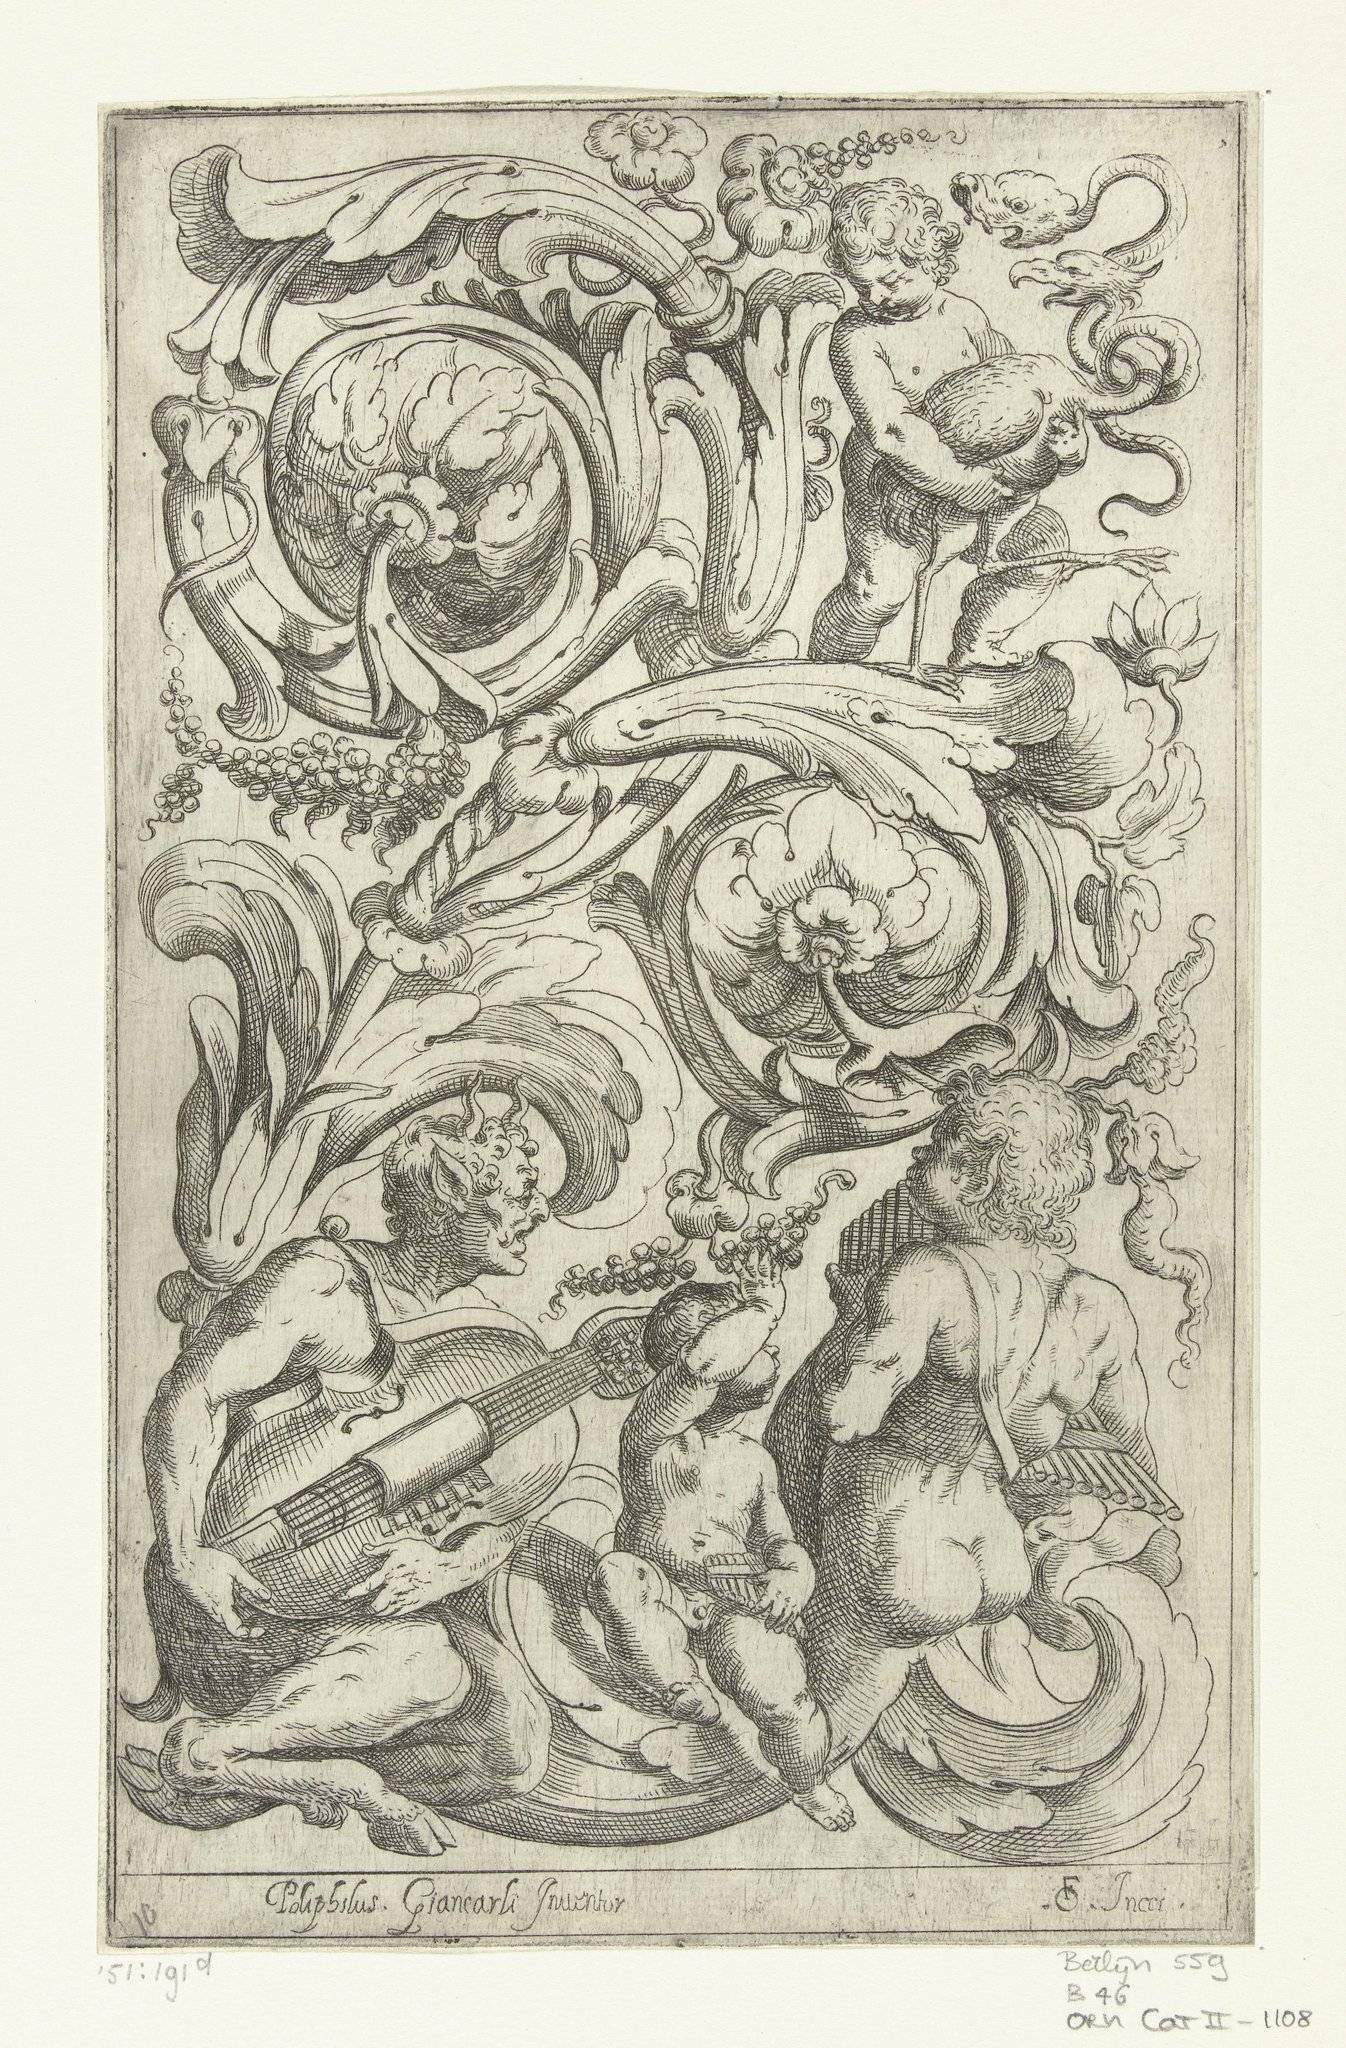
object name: print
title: Disegni varii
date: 1625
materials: paper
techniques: etching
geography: venice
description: De drie figuren onderaan hebben muziekinstrumenten vast.